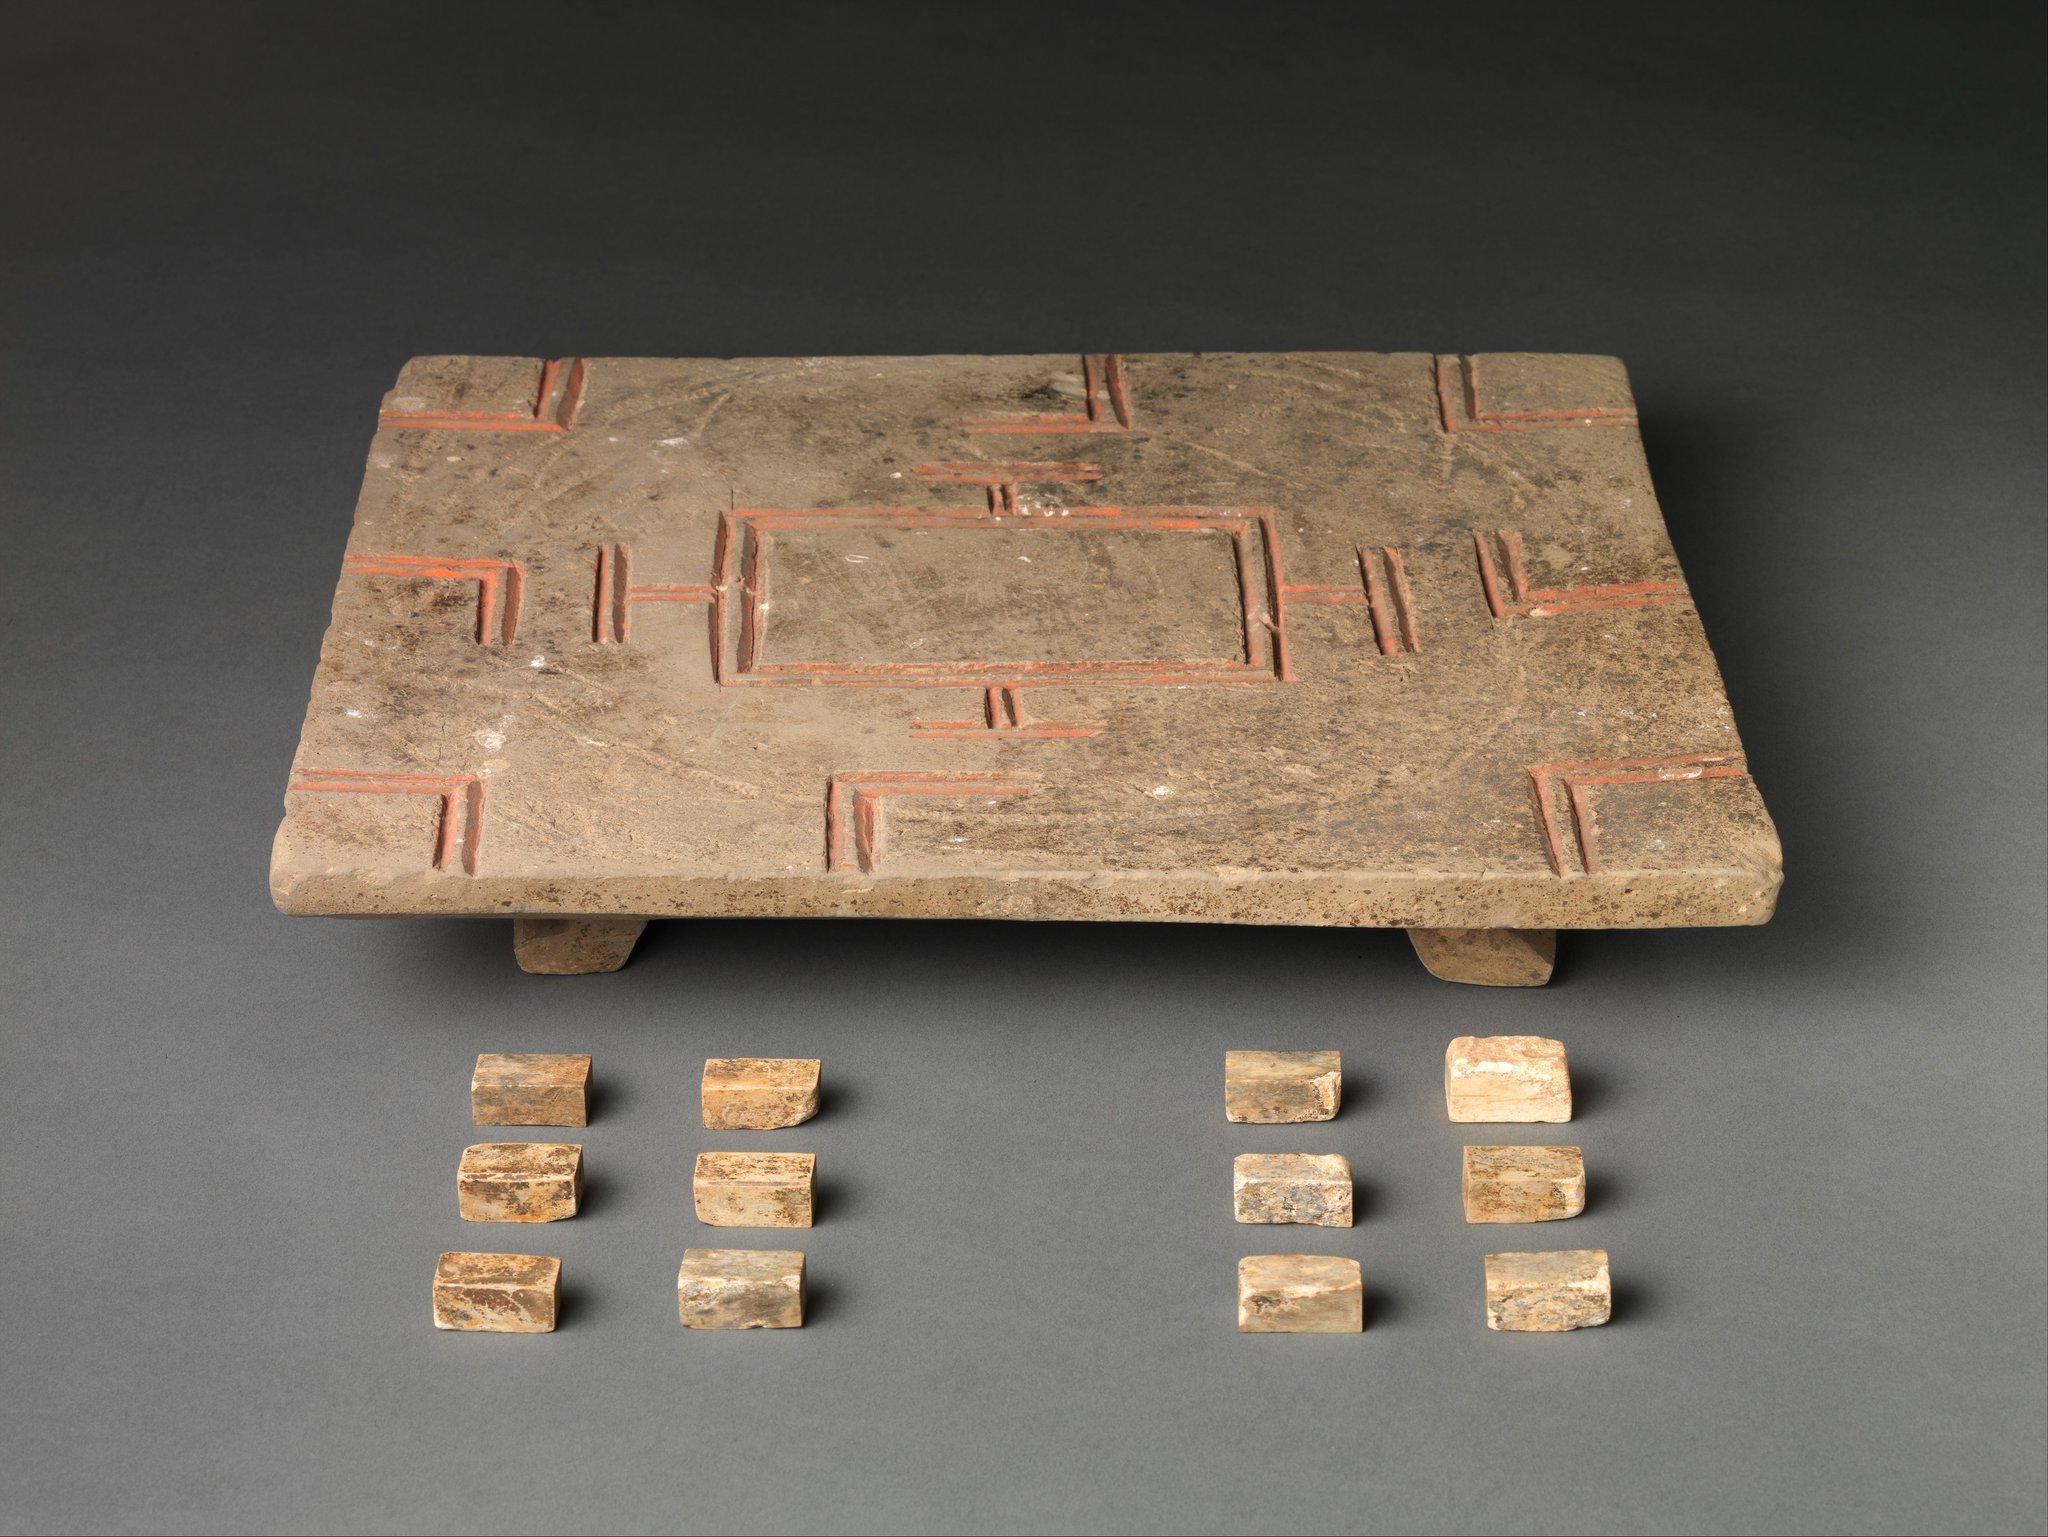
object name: game board and piece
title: Liubo Board and Pieces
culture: chinese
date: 100 BCE-100 CE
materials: bone, earthenware, pigment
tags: games